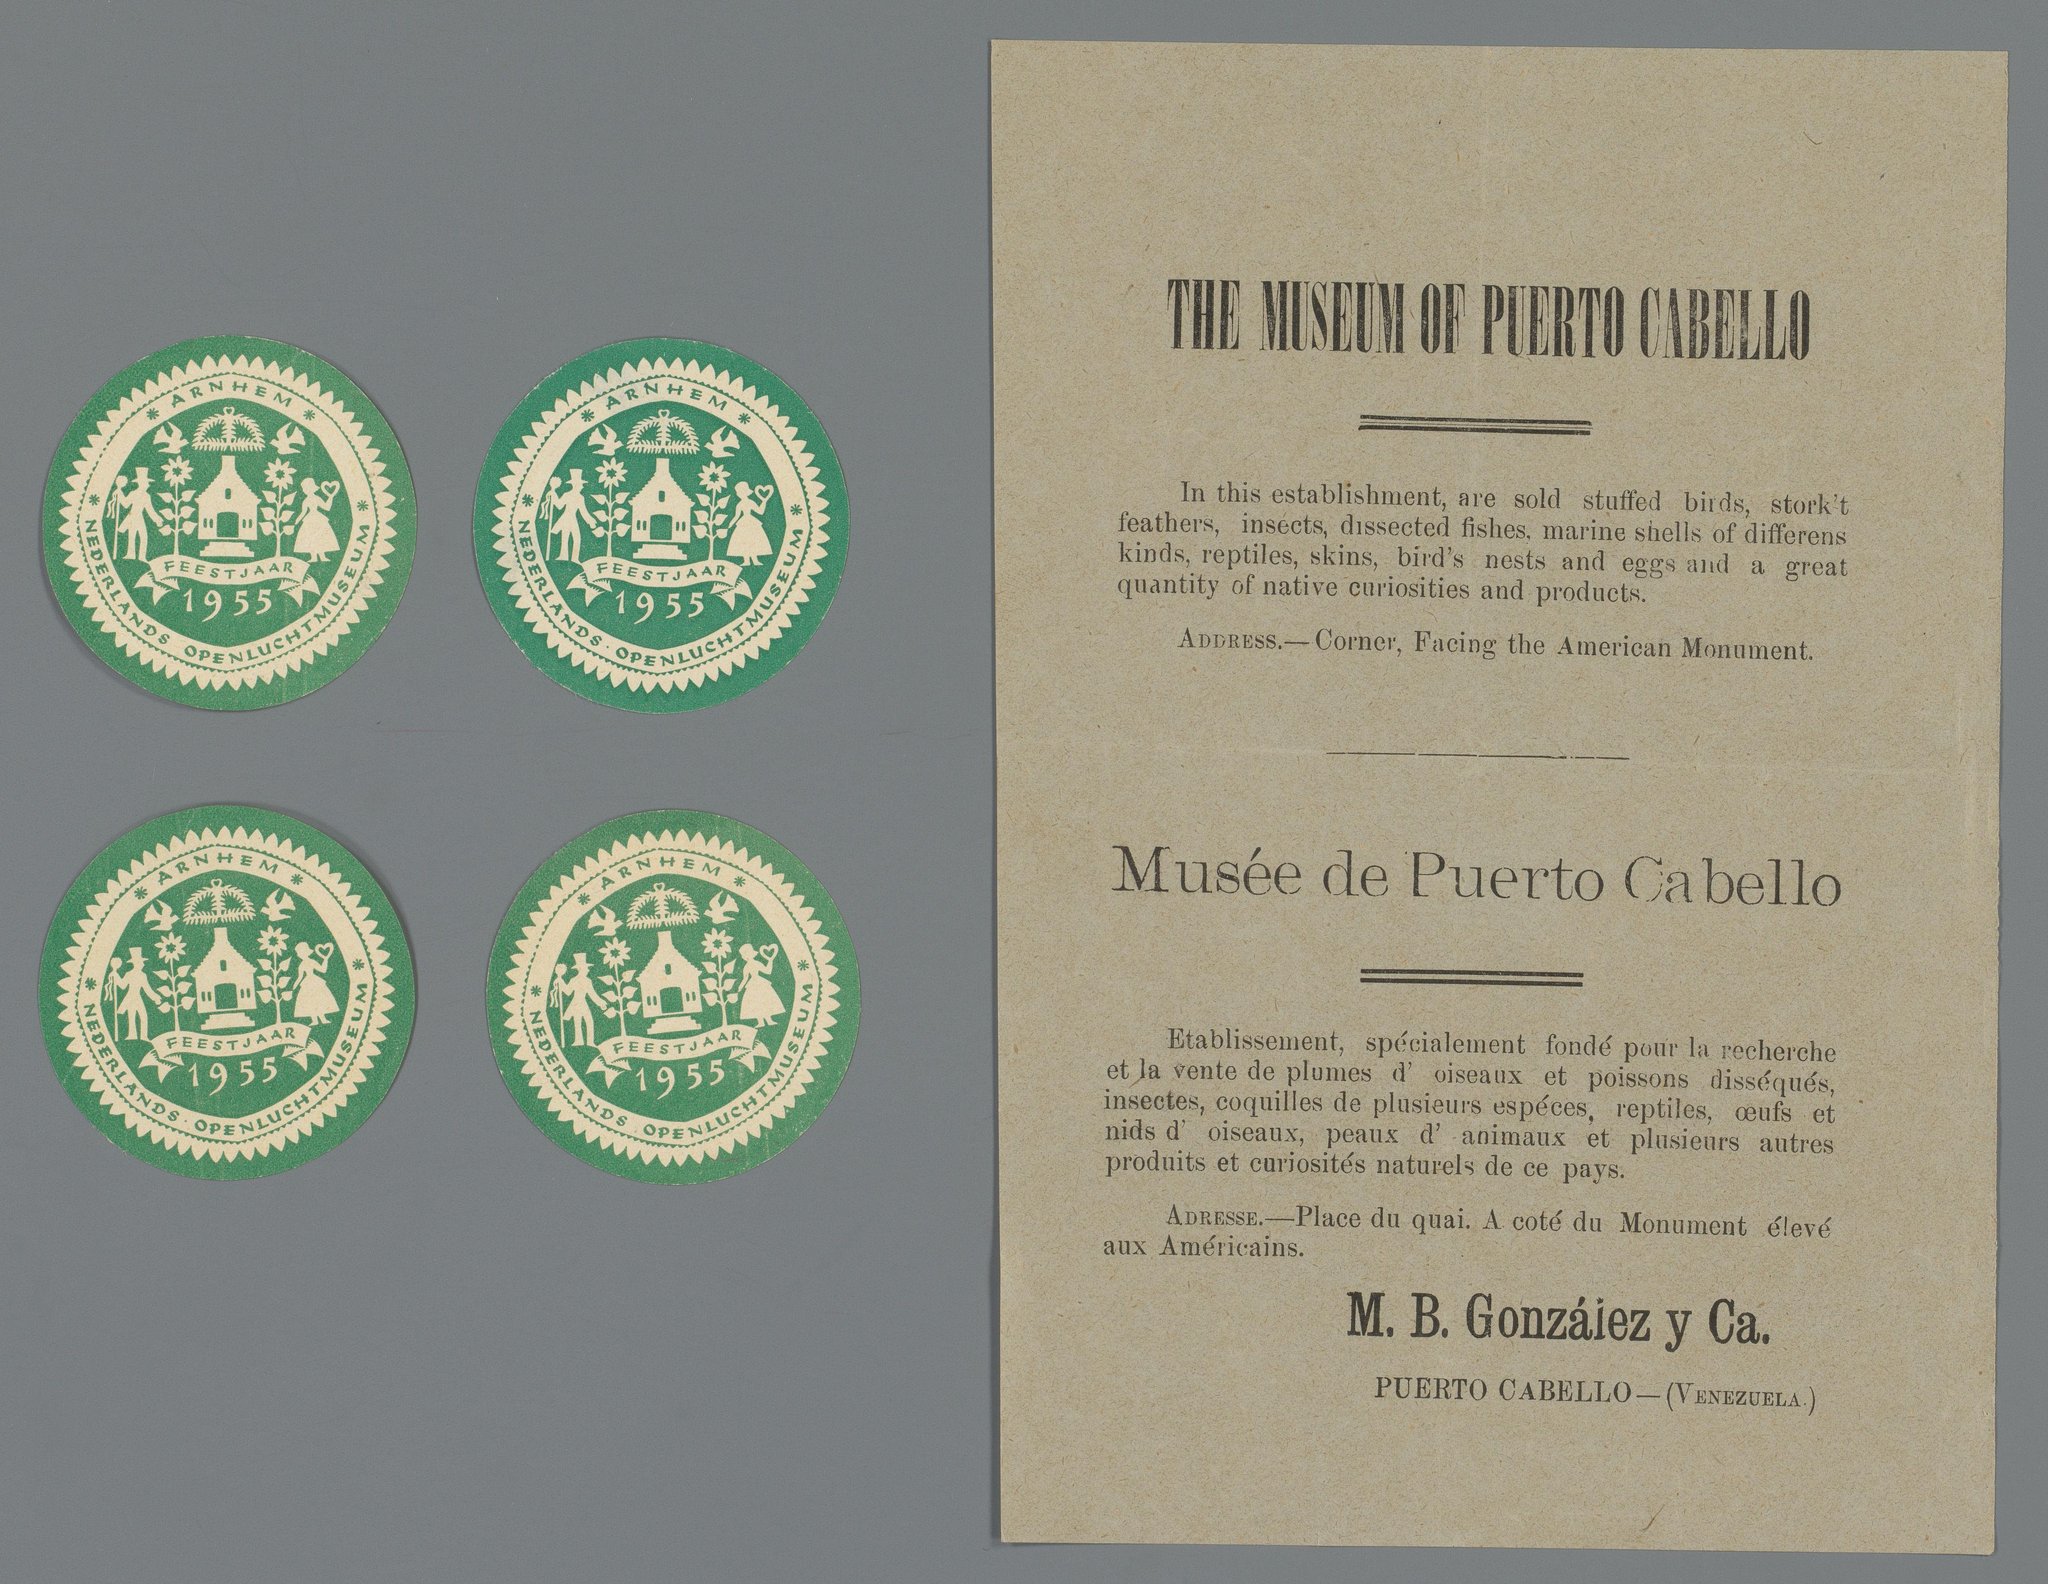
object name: document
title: Stickers van het Nederlands Openluchtmuseum en folder van het Museum van Puerto Cabello in Venezuela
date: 1930-1955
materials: gum, paper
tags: advertising, permanent exhibition, museum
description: Cluster van 5 bladen, met vier identieke groene plaketiketten voor het feestjaar van het Nederlands Openluchtmuseum in 1955 en een folder voor het Museum van Puerto Cabello in Venezuela.